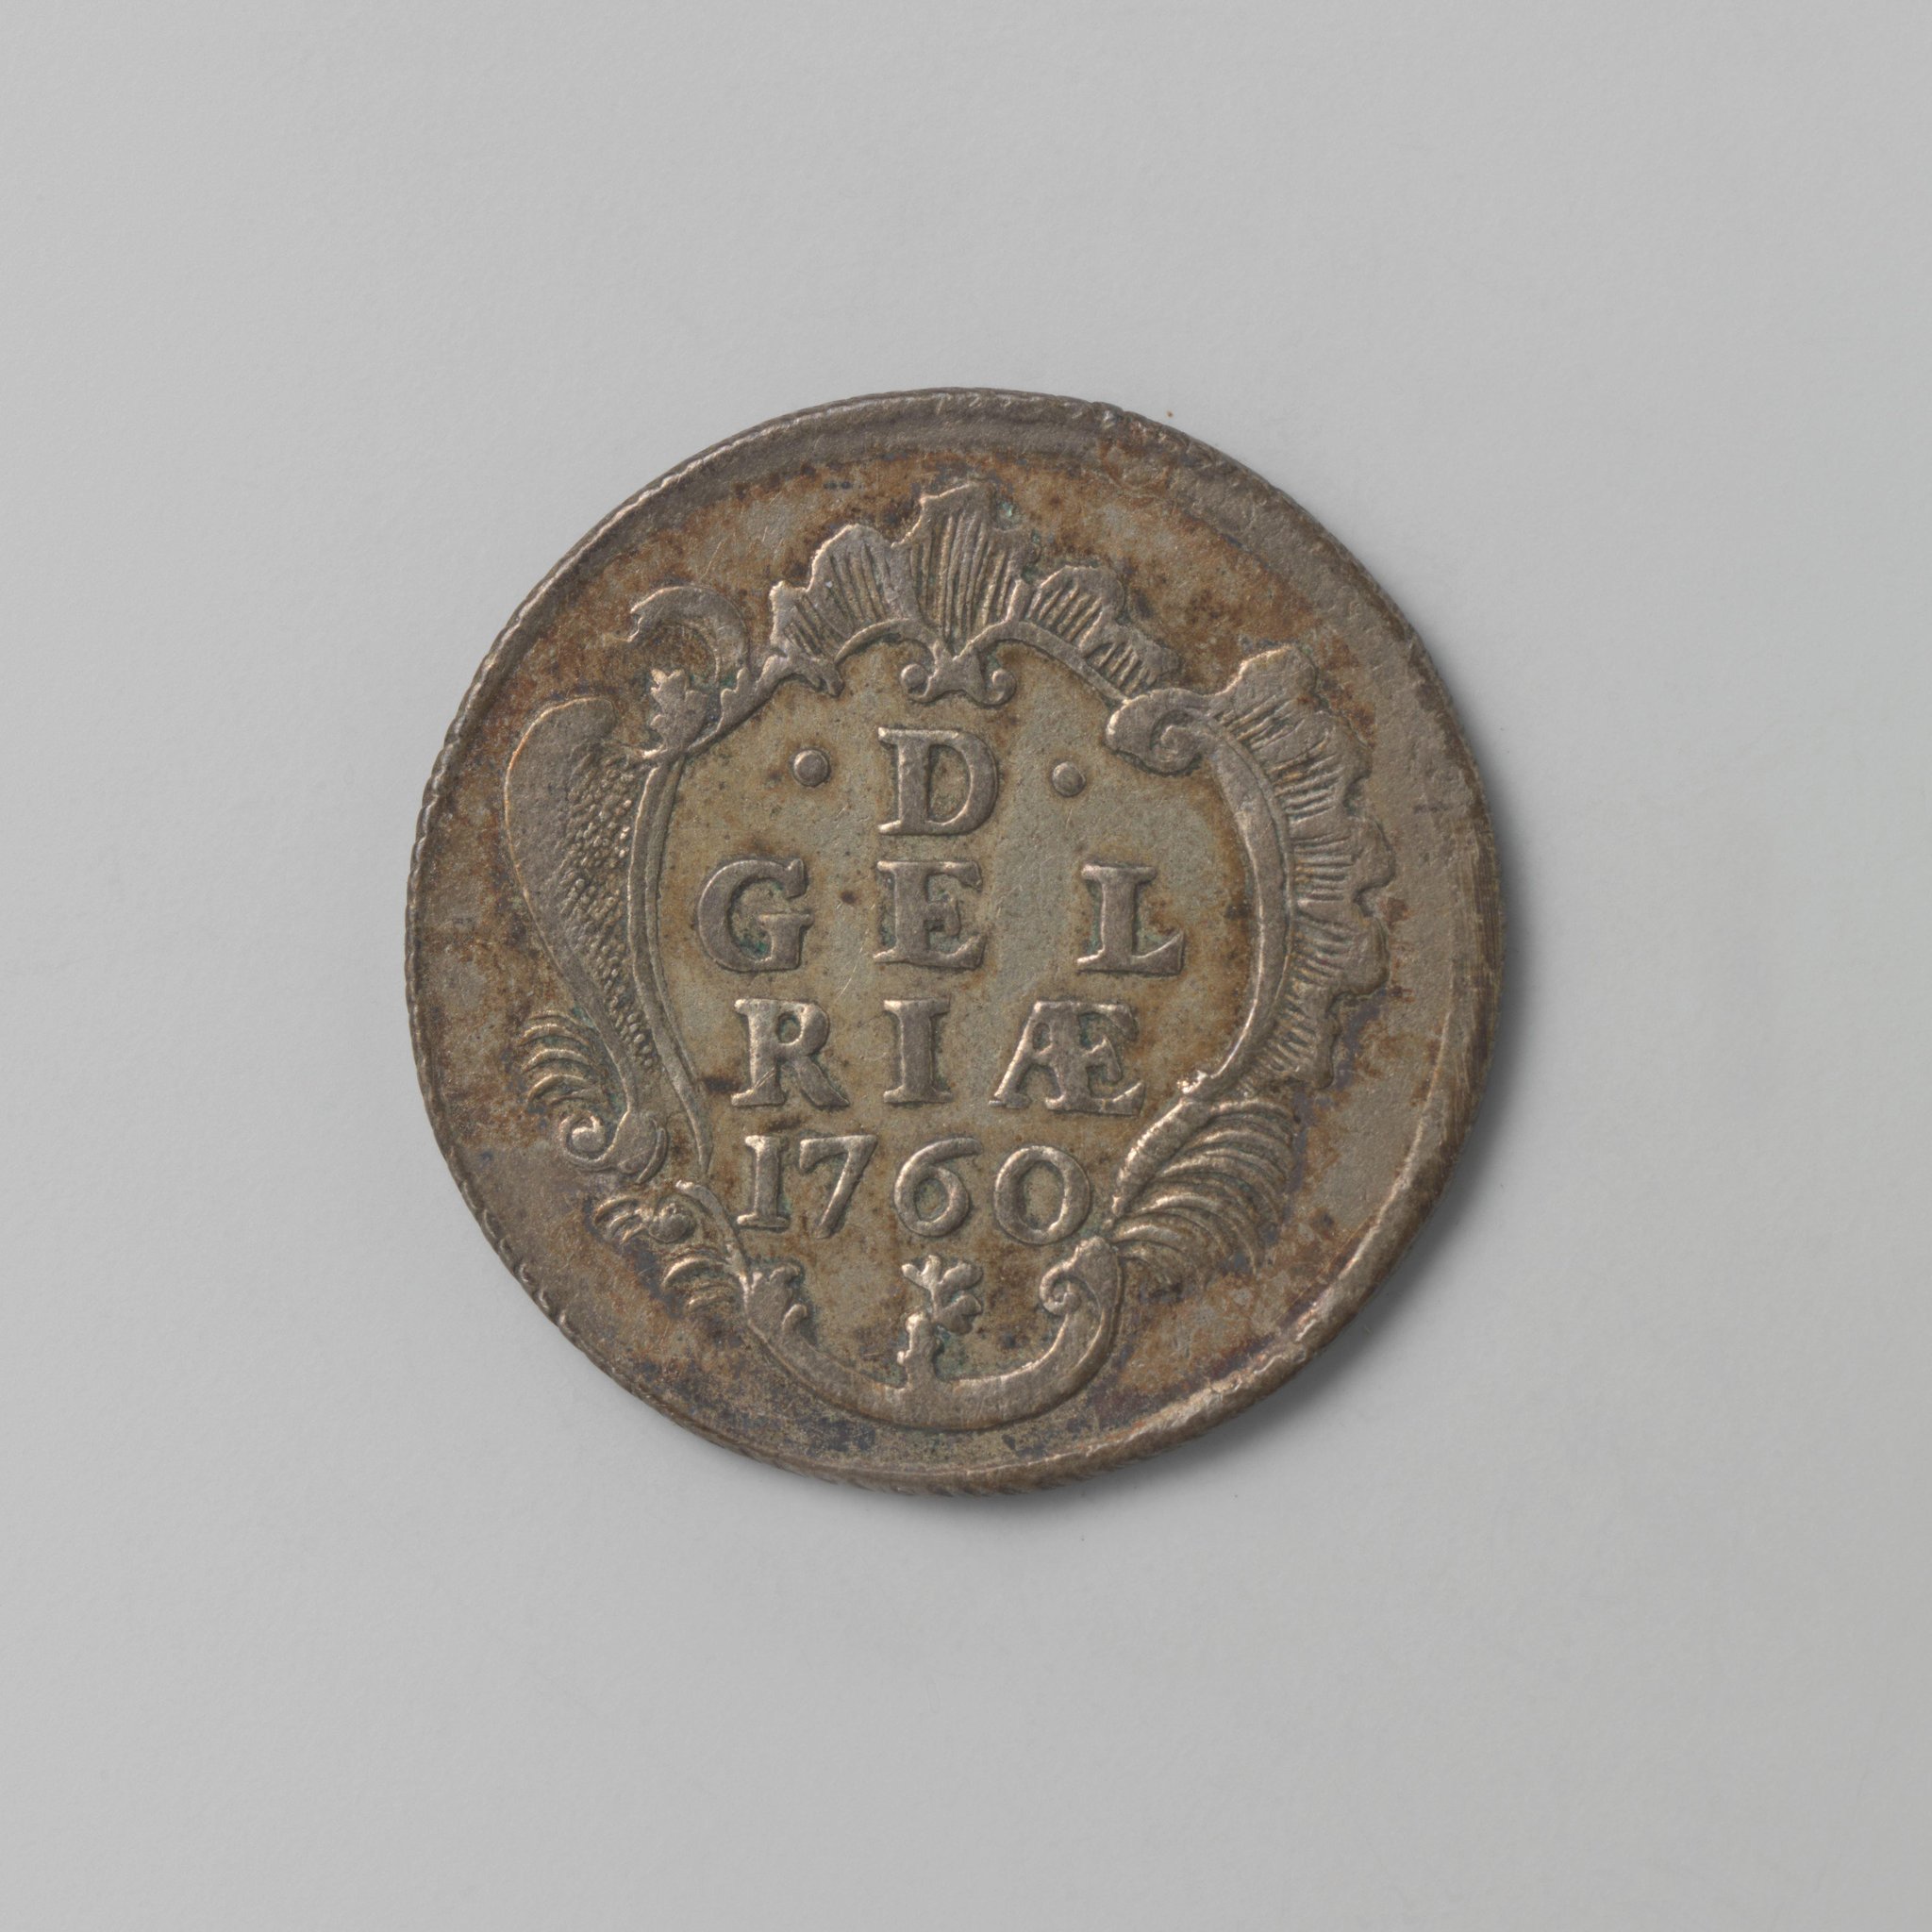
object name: coin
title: Gelderland, duit, 1760. Zilveren afslag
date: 1760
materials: silver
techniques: striking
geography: harderwijk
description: Zilveren munt. Voorzijde: binnen weelderige rococo-versiering in drie regels D/GEL/RIAE, daaronder jaartal en muntmeesterteken. Keerzijde: gekroond Gelders wapenschild. Afslag in zilver.